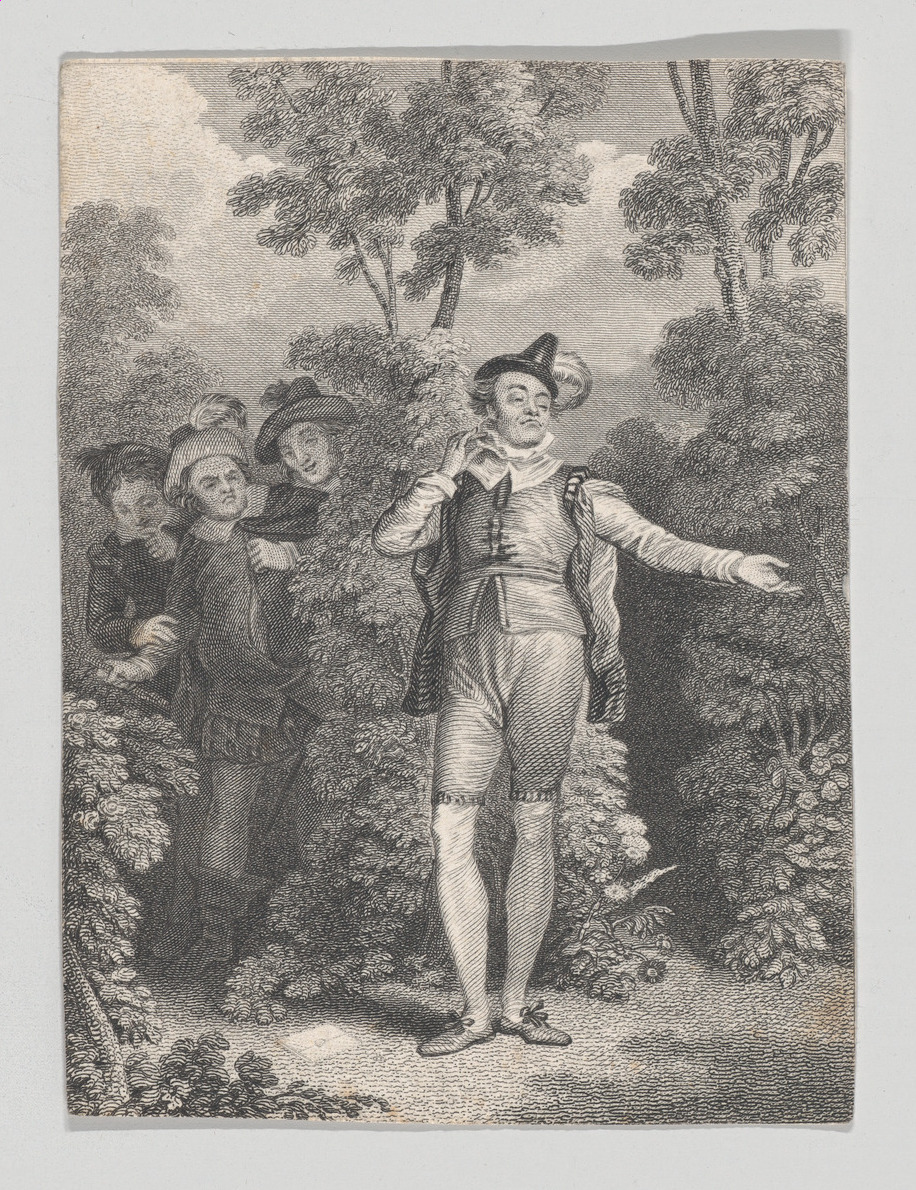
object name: print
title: Malvolio (Twelfth Night, Act 2, Scene 5)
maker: charles heath, the elder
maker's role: engraver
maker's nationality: british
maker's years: 1785-1848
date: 1825-1840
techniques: engraving, etching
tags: shakespeare,men